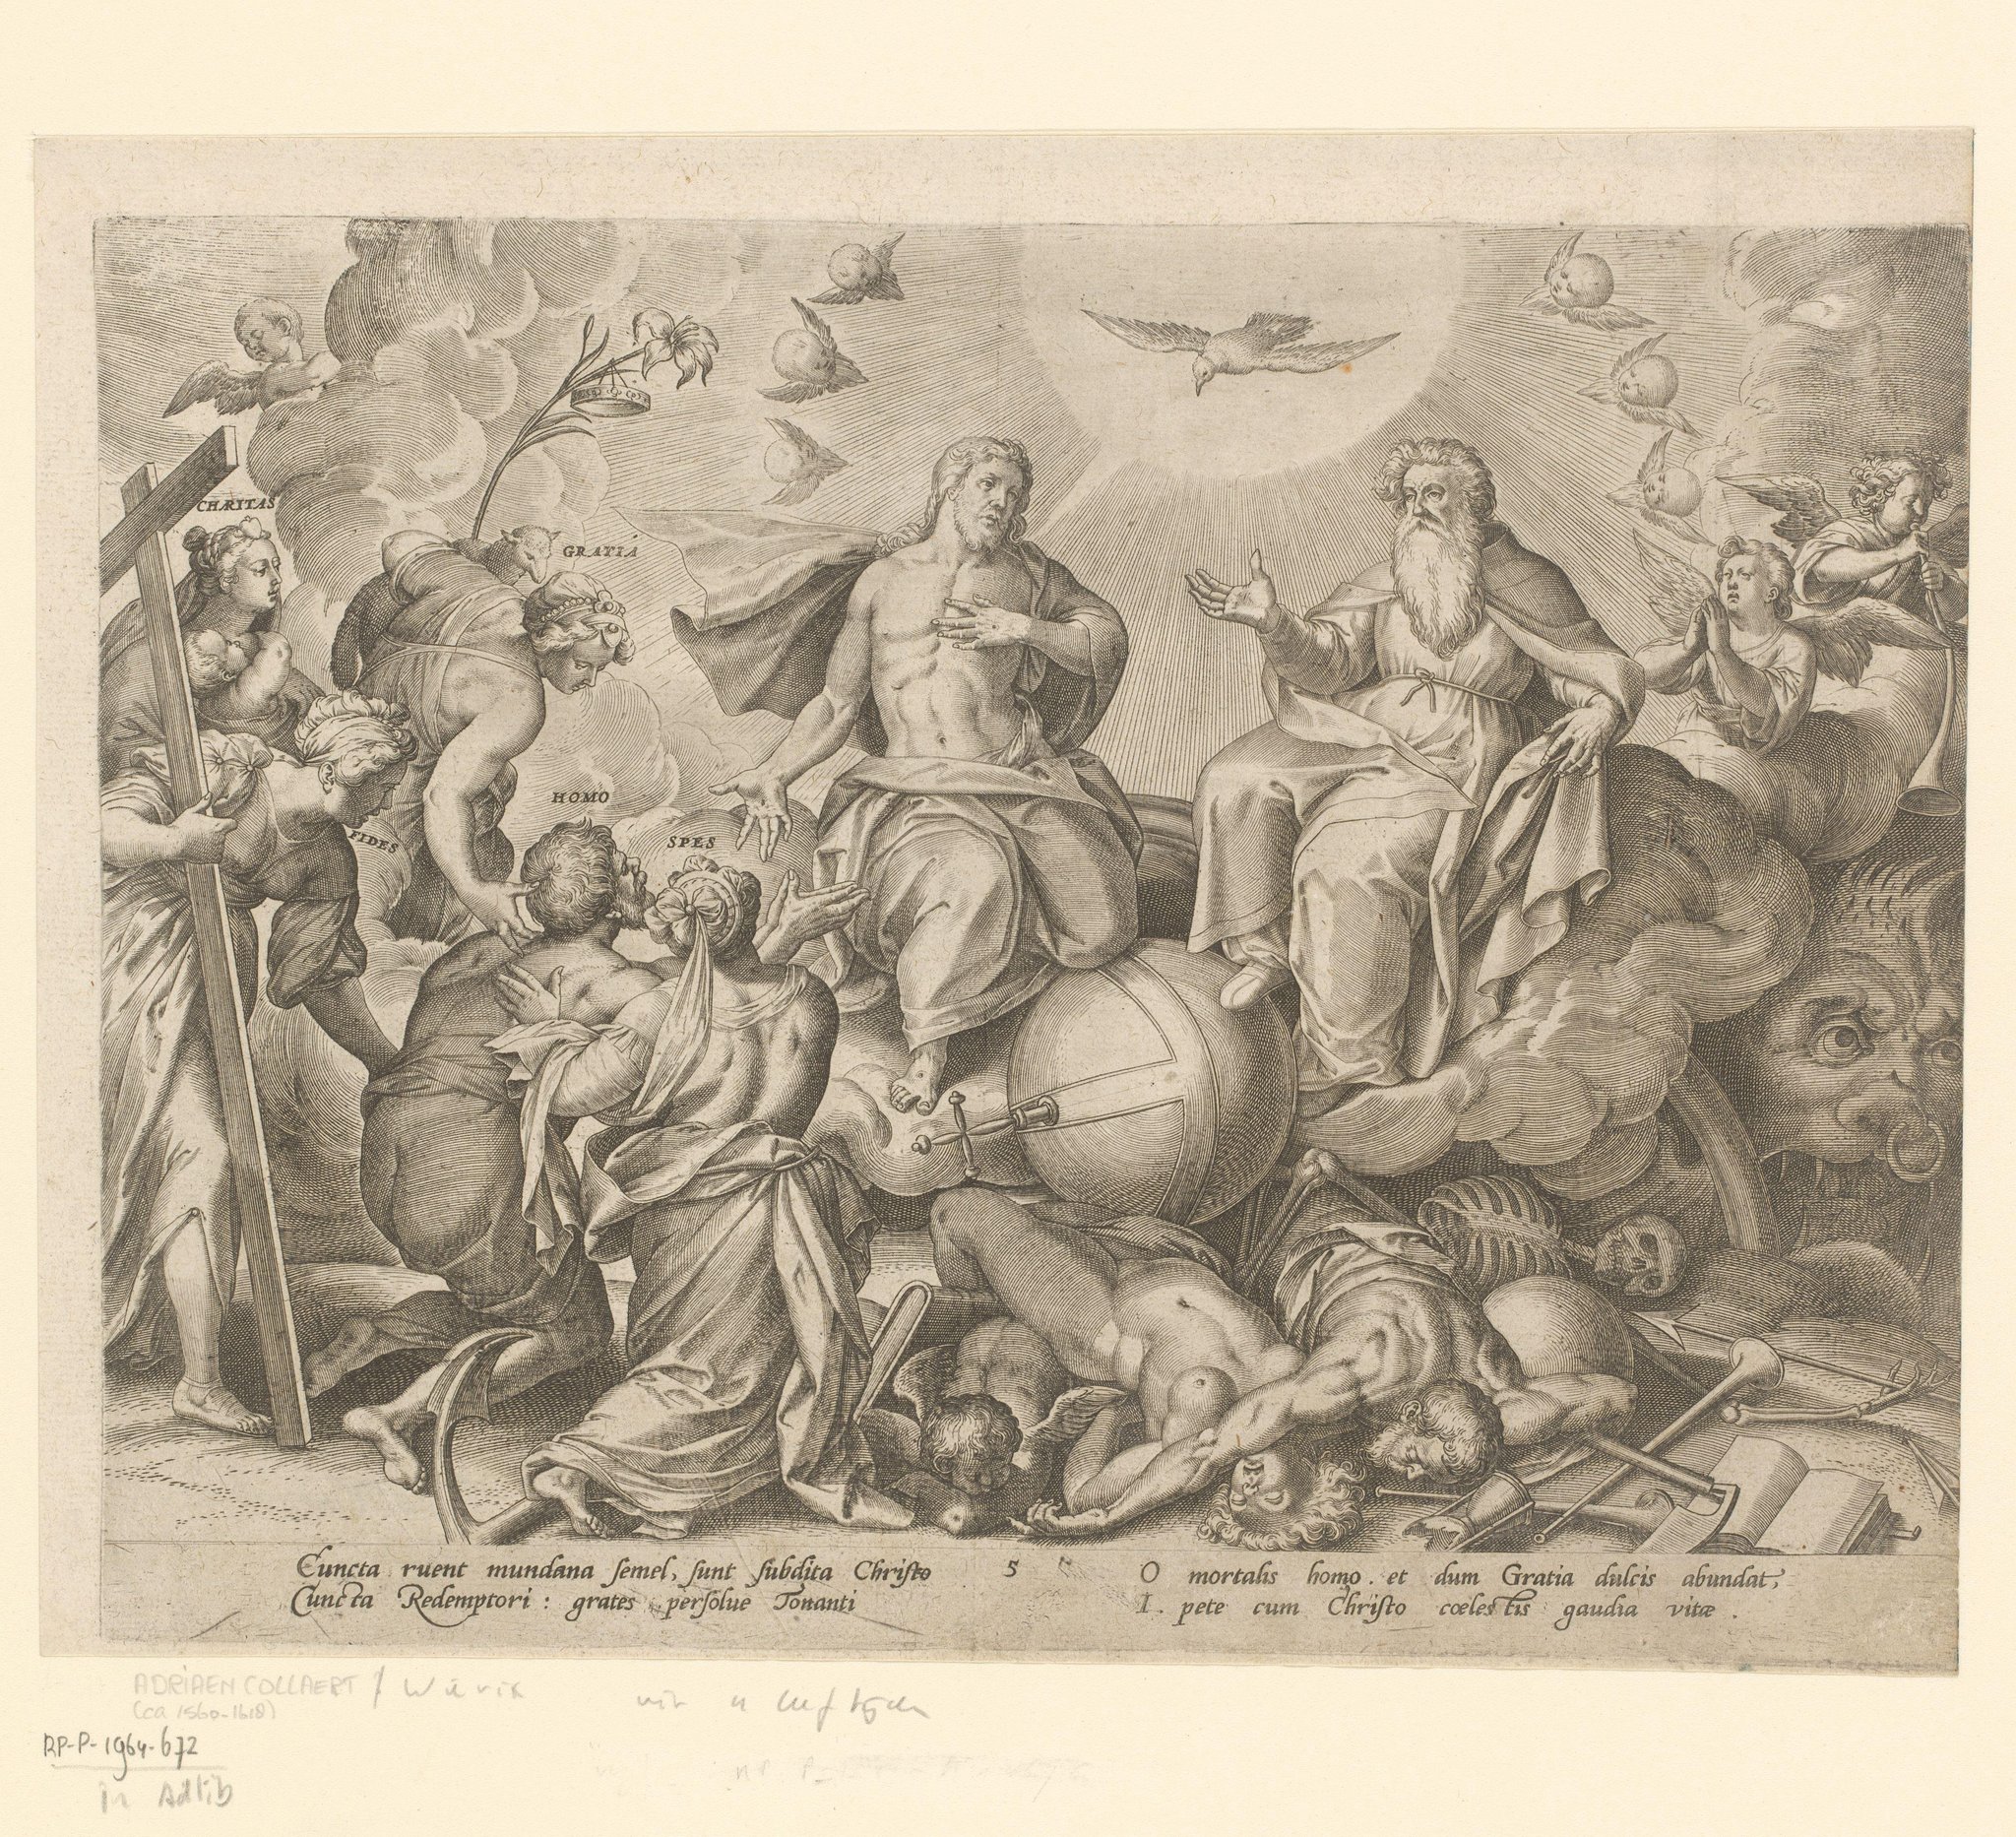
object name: print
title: Laatste Oordeel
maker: hieronymus wierix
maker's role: draughtsman, print maker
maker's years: 1553-1619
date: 1563-1584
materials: paper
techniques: engraving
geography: antwerp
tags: the three theological virtues, last judgement, the holy trinity, 'trinitas coelestis'; father, son and holy ghost ~ christian religion, entrance of hell as monstrous mouth (of leviathan), death of human being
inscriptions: collector's mark: Lugt 2228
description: Allegorie op de dood, gesymboliseerd door het Laatste Oordeel. De Mens (Homo), omringd door de goddelijke deugden (Charitas, Fides en Spes) en Goddelijke Genade (Gratia), knielt in aanbidding voor de Drie-eenheid. Op de voorgrond liggen dode mensen aan de rand van de poort naar de hel. In de marge een vierregelig onderschrift, in twee kolommen, in het Latijn.